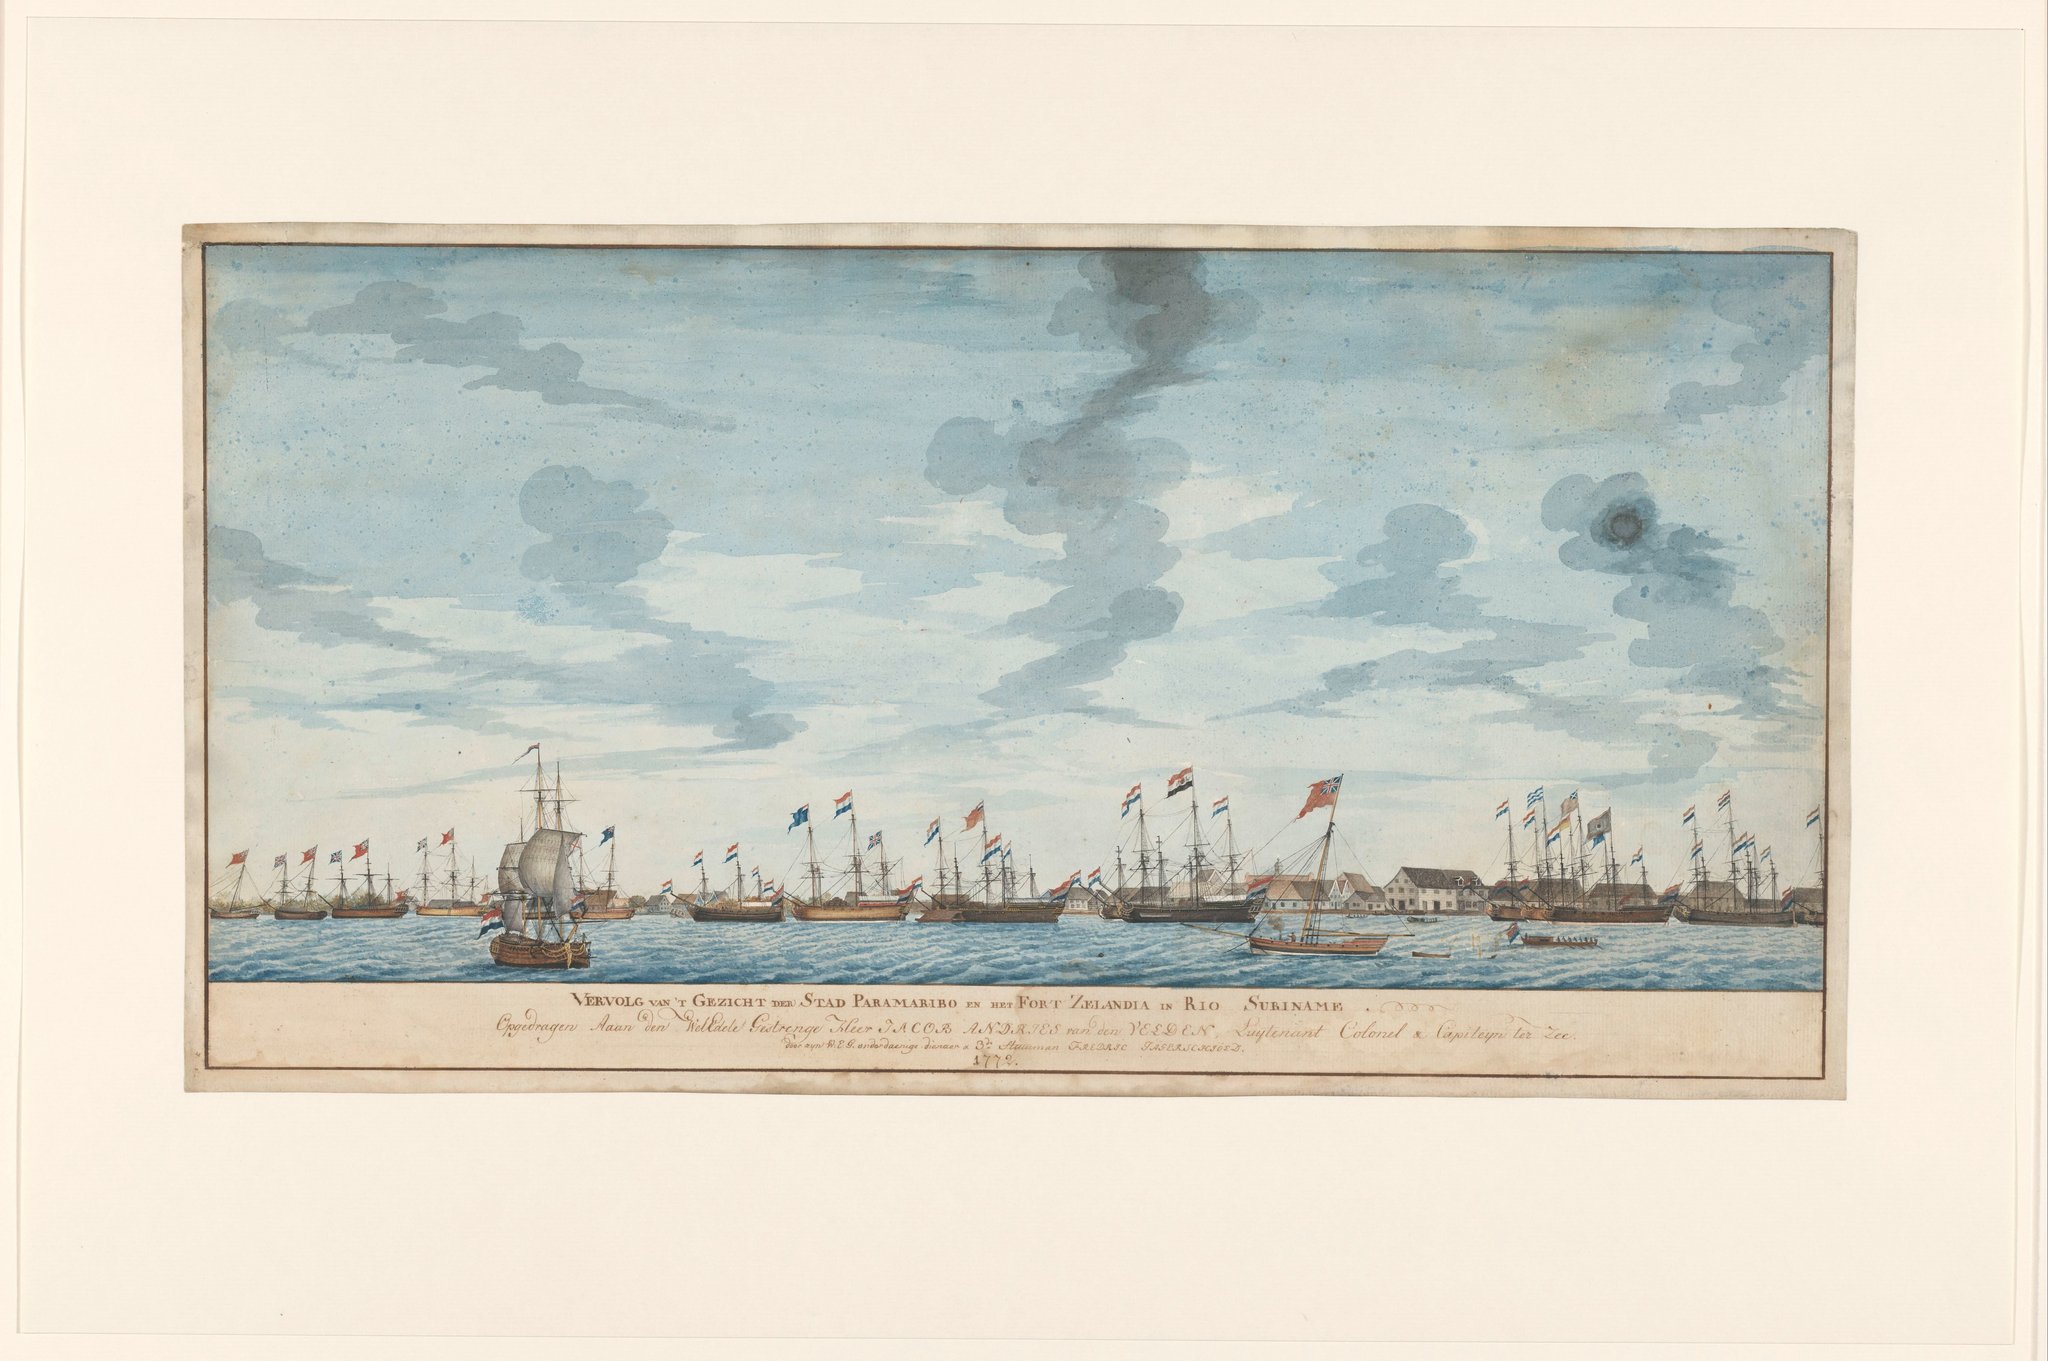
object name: drawing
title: Gezicht op de stad Paramaribo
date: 1772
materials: ink, paper, watercolor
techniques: brush, pen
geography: paramaribo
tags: harbour, sailing-ship, sailing-boat, prospect of city, town panorama, silhouette of city (+ city(-scape) with figures, staffage), suriname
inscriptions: signature, date and inscription: ‘VERVOLG VAN 'T GEZICHT VAN EEN GEDEELTE DER STAD PARAMARIBO EN HET FORT ZELANDIA IN RIO SURINAME. / Opgedragen Aan den WelEdele Gestrenge Heer JACOB ANDRIES van den VELDEN, Luytenant Colonel & Capiteyn ter Zee. / Door zijn W:E:G: onderdaenige dienaer & thans 3de Stuurman FREDERIC de JAGERSCHIOLD. FREDERIC de JAGERSCHIOLD. 1772.’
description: Huizen aan het water onder grote wolkenlucht. Vele schepen op de rede voor een stad (Paramaribo). Links voor een boot onder zeil met Nederlandse vlag.